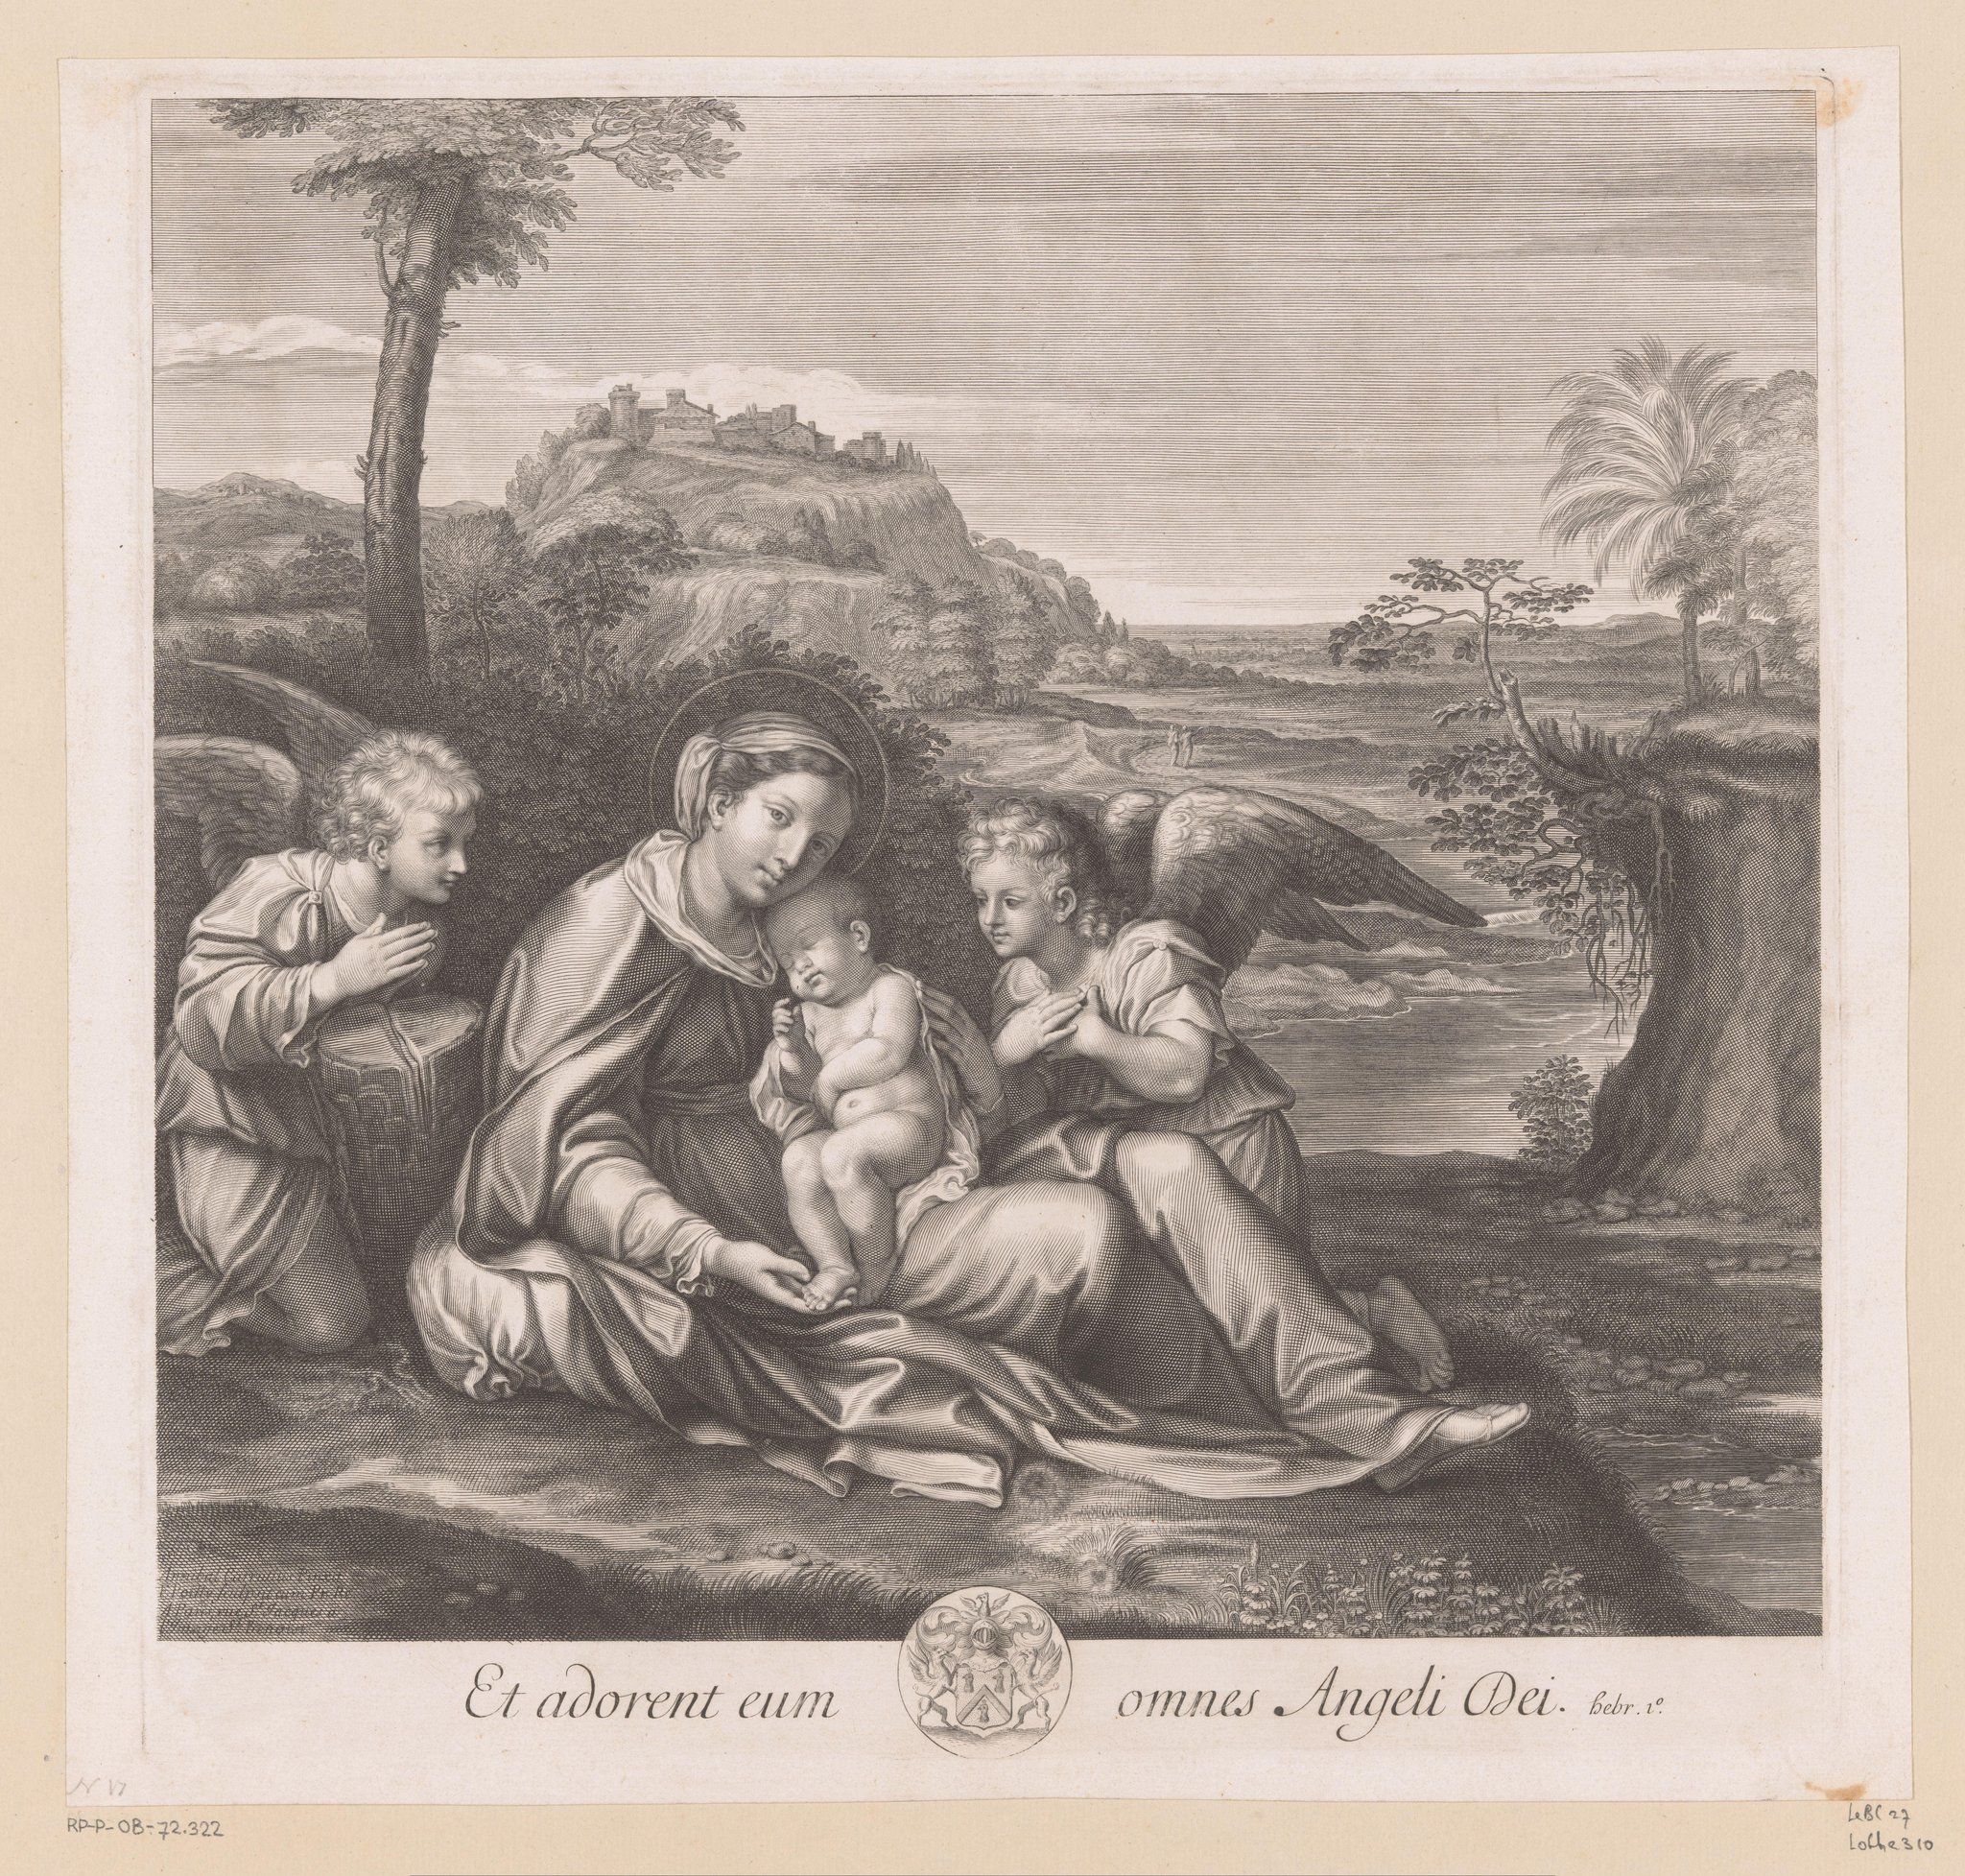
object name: print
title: Maria met slapend Christuskind en twee engelen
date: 1632-1693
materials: paper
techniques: engraving, etching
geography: france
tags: christ-child sleeping ~ madonna-representations (+ angel(s))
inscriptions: collector's mark: Lugt 240